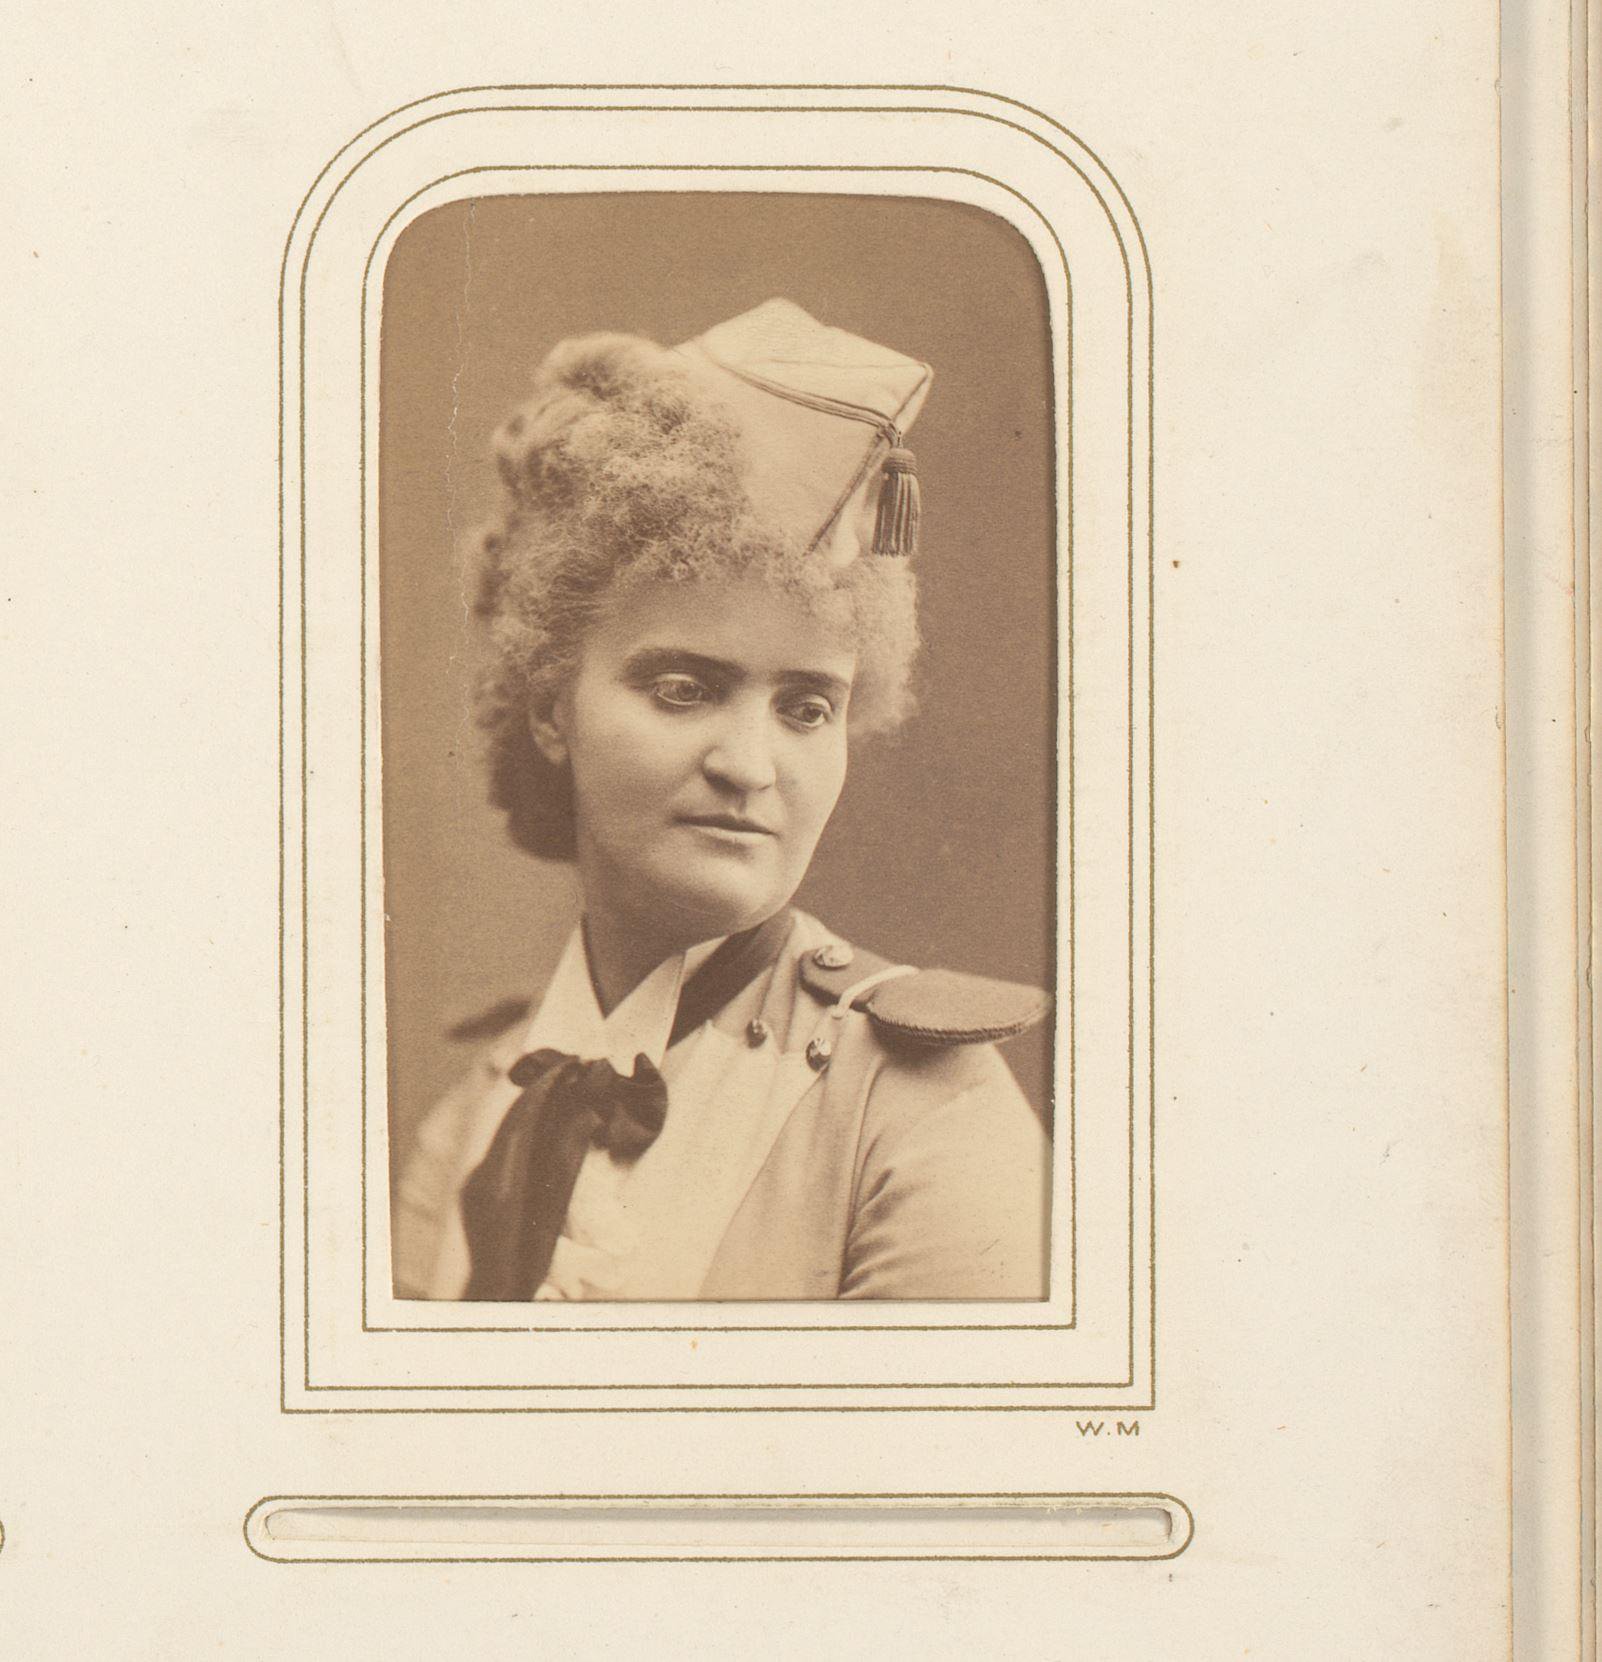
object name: album leaf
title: Portret van Signe Hebbe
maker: gösta florman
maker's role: fotograaf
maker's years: 1831-1900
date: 1870-1885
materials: cardboard, photographic support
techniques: albumen print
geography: stockholm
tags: historical persons - bb - woman, portrait of opera-singer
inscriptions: monogram: ‘GF’, annotation: ‘Signe Hebbe/ 1837 - 1925’, inscription: ‘GÖSTA FLORMAN/ Regeringsgatan 28.A./ STOCKHOLM.’